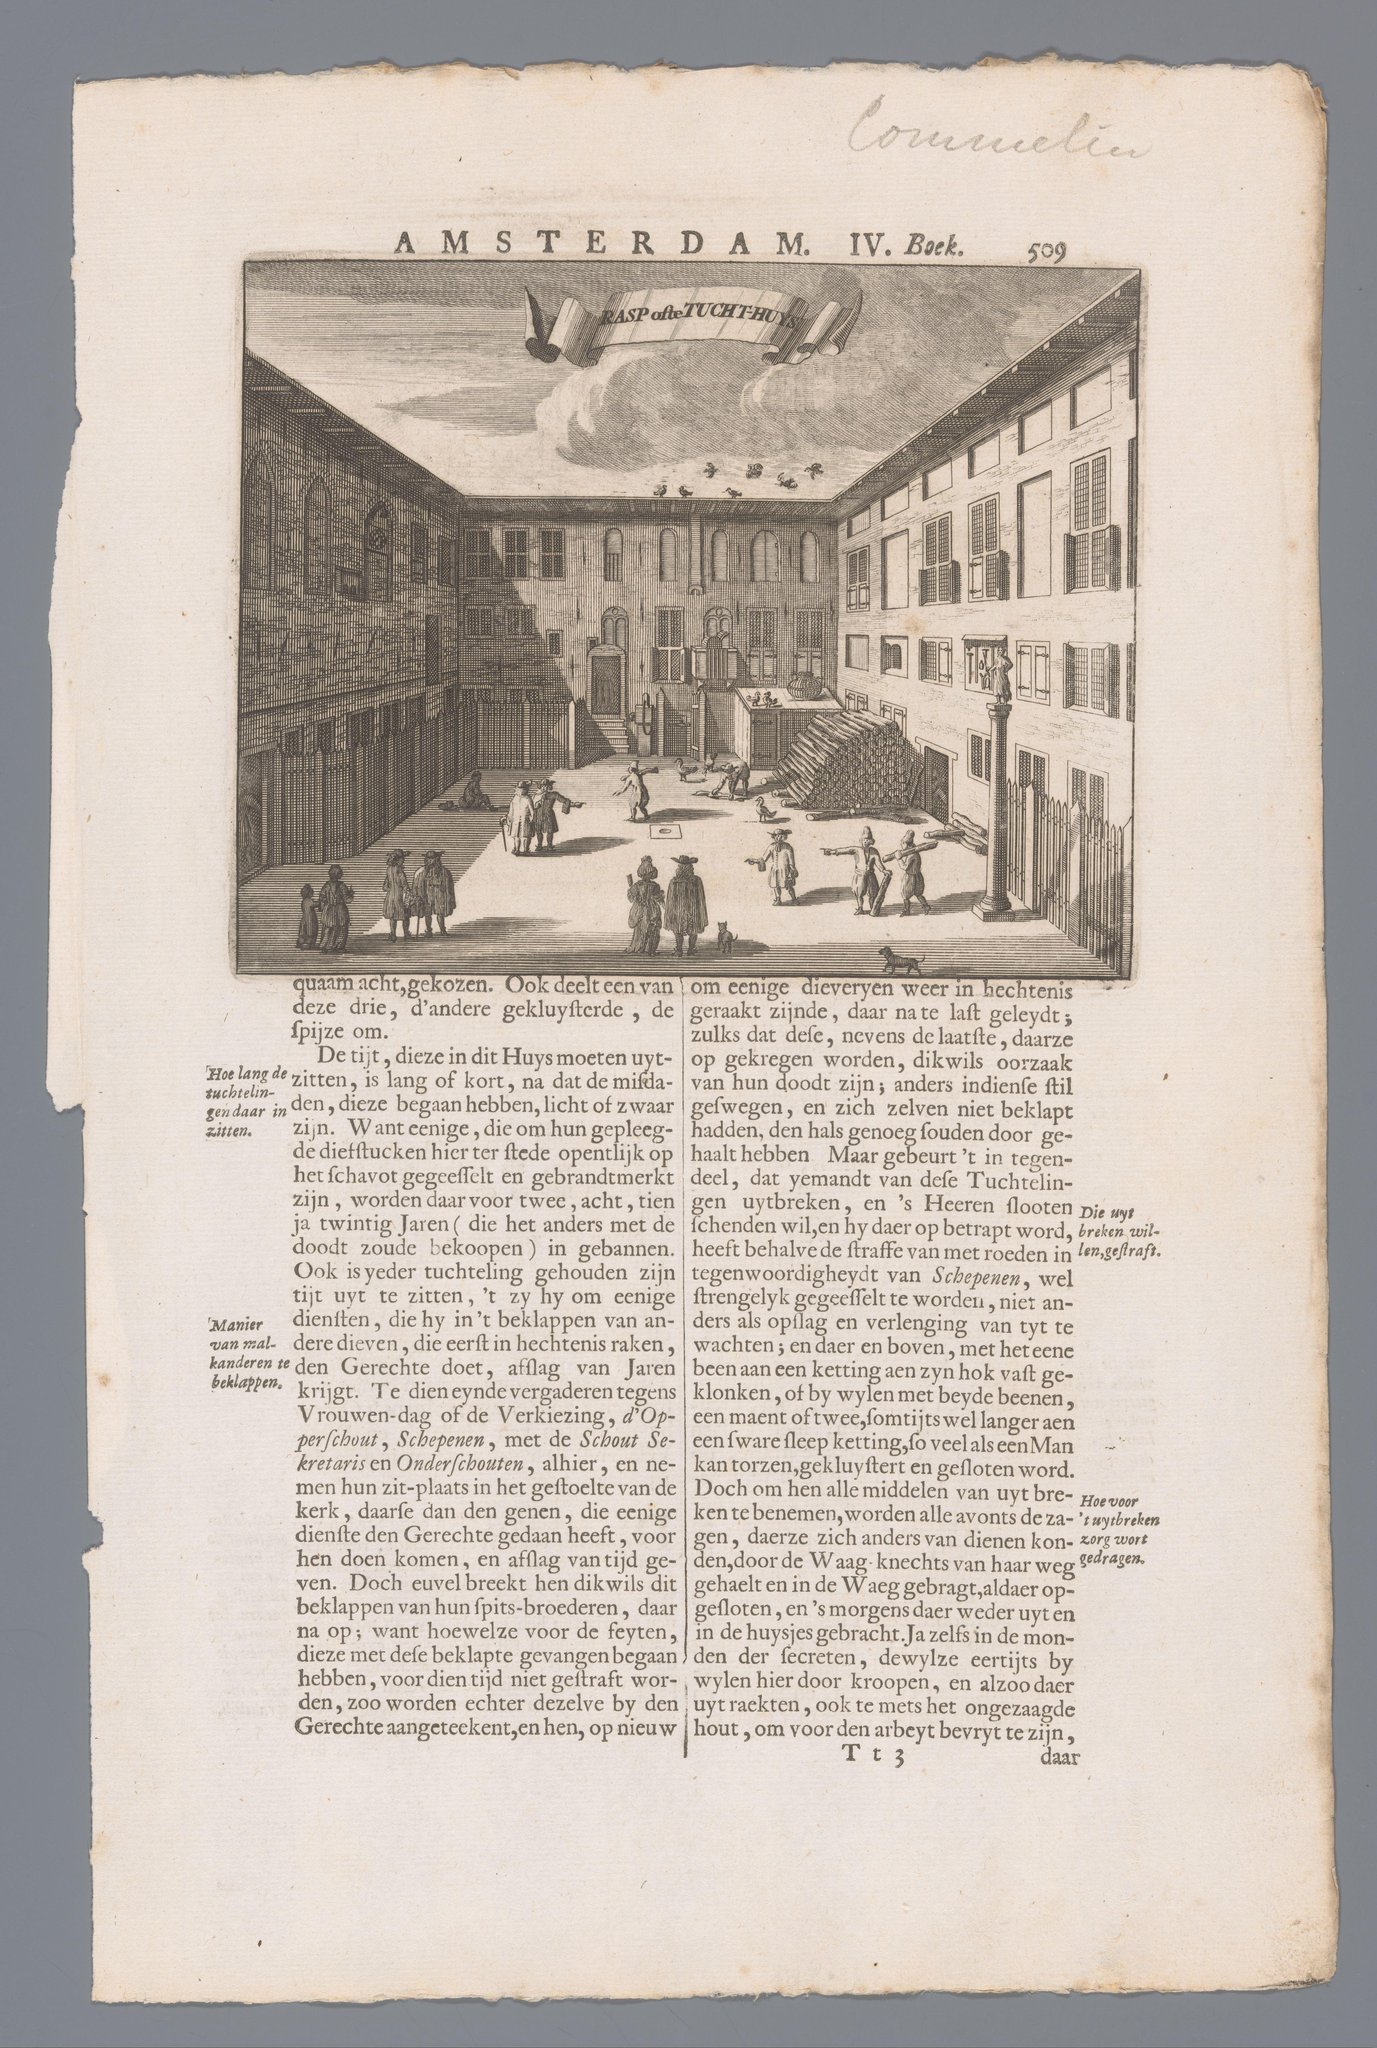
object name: book illustration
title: Rasp ofte Tucht-huys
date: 1726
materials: paper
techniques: etching, letterpress printing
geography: amsterdam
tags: prison, jail, (prisoners) in the prison yard, justitia (justice) as roman personification, workhouse, penal camp, penitentiary, chain gang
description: Prent uit: Commelin, Caspar. Beschryvinge van Amsterdam (…). 2e druk. Amsterdam: Andries van Damme, Johannes Ratelband, weduwe Antony van Aeltwijk en Hermanus Uytwerf, 1726, dl. 1, p. 509.